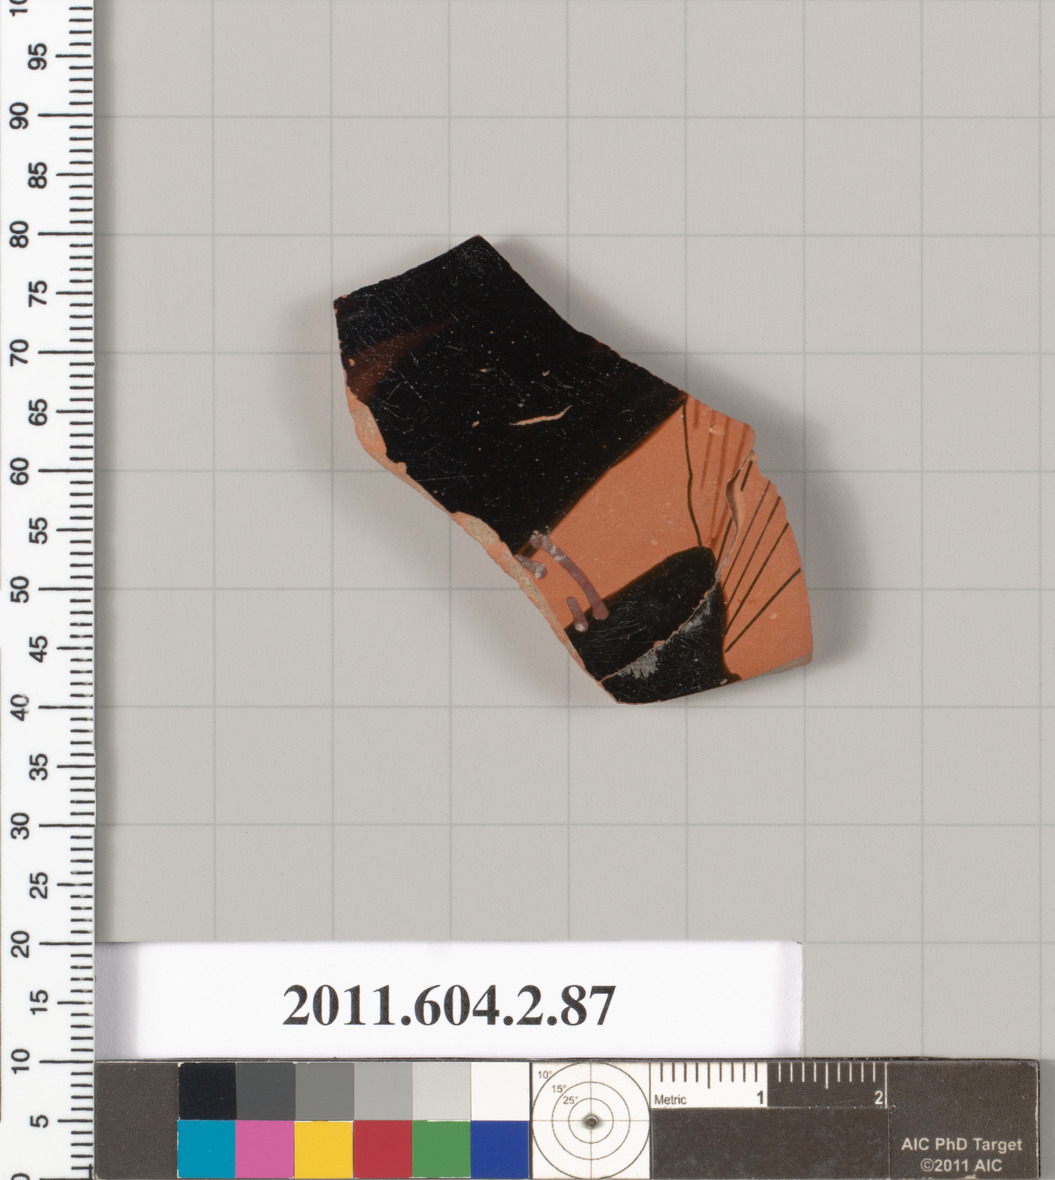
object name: pelike fragment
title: Terracotta fragment of a pelike (jar)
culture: greek, attic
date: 490-470 BCE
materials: terracotta